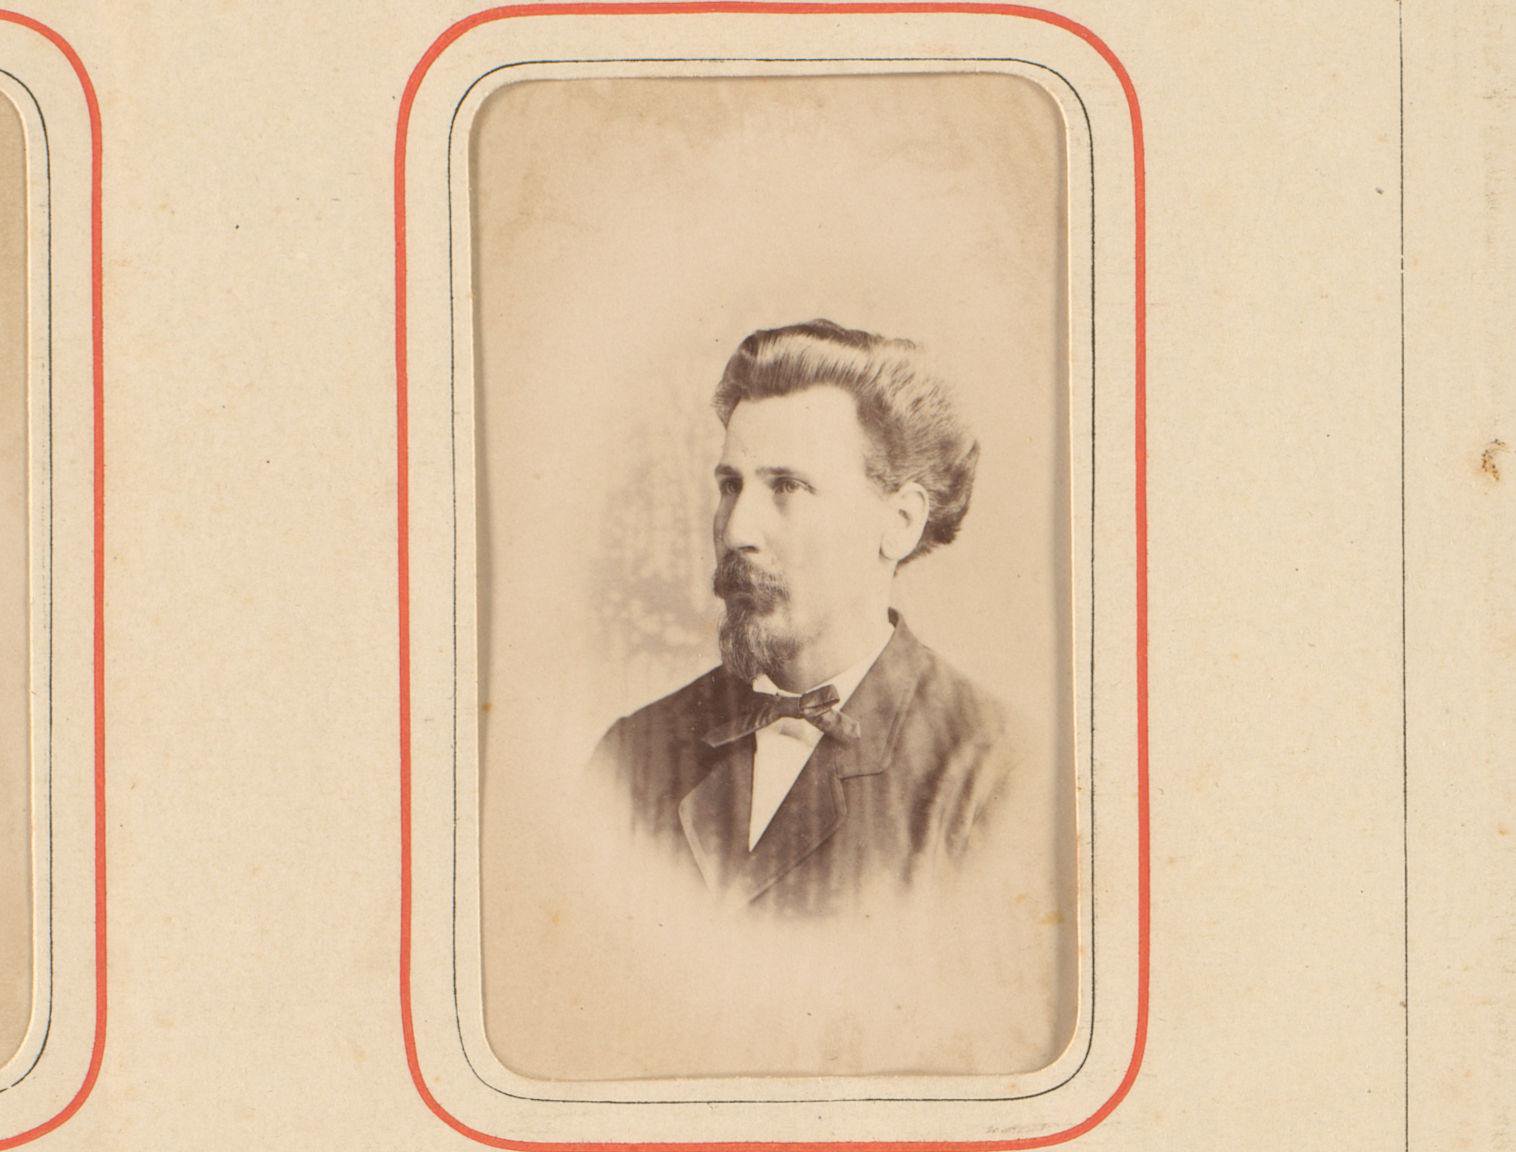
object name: photograph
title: Portret van een onbekende man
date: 1871-1890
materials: cardboard, paper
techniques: albumen print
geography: batavia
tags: anonymous historical person portrayed